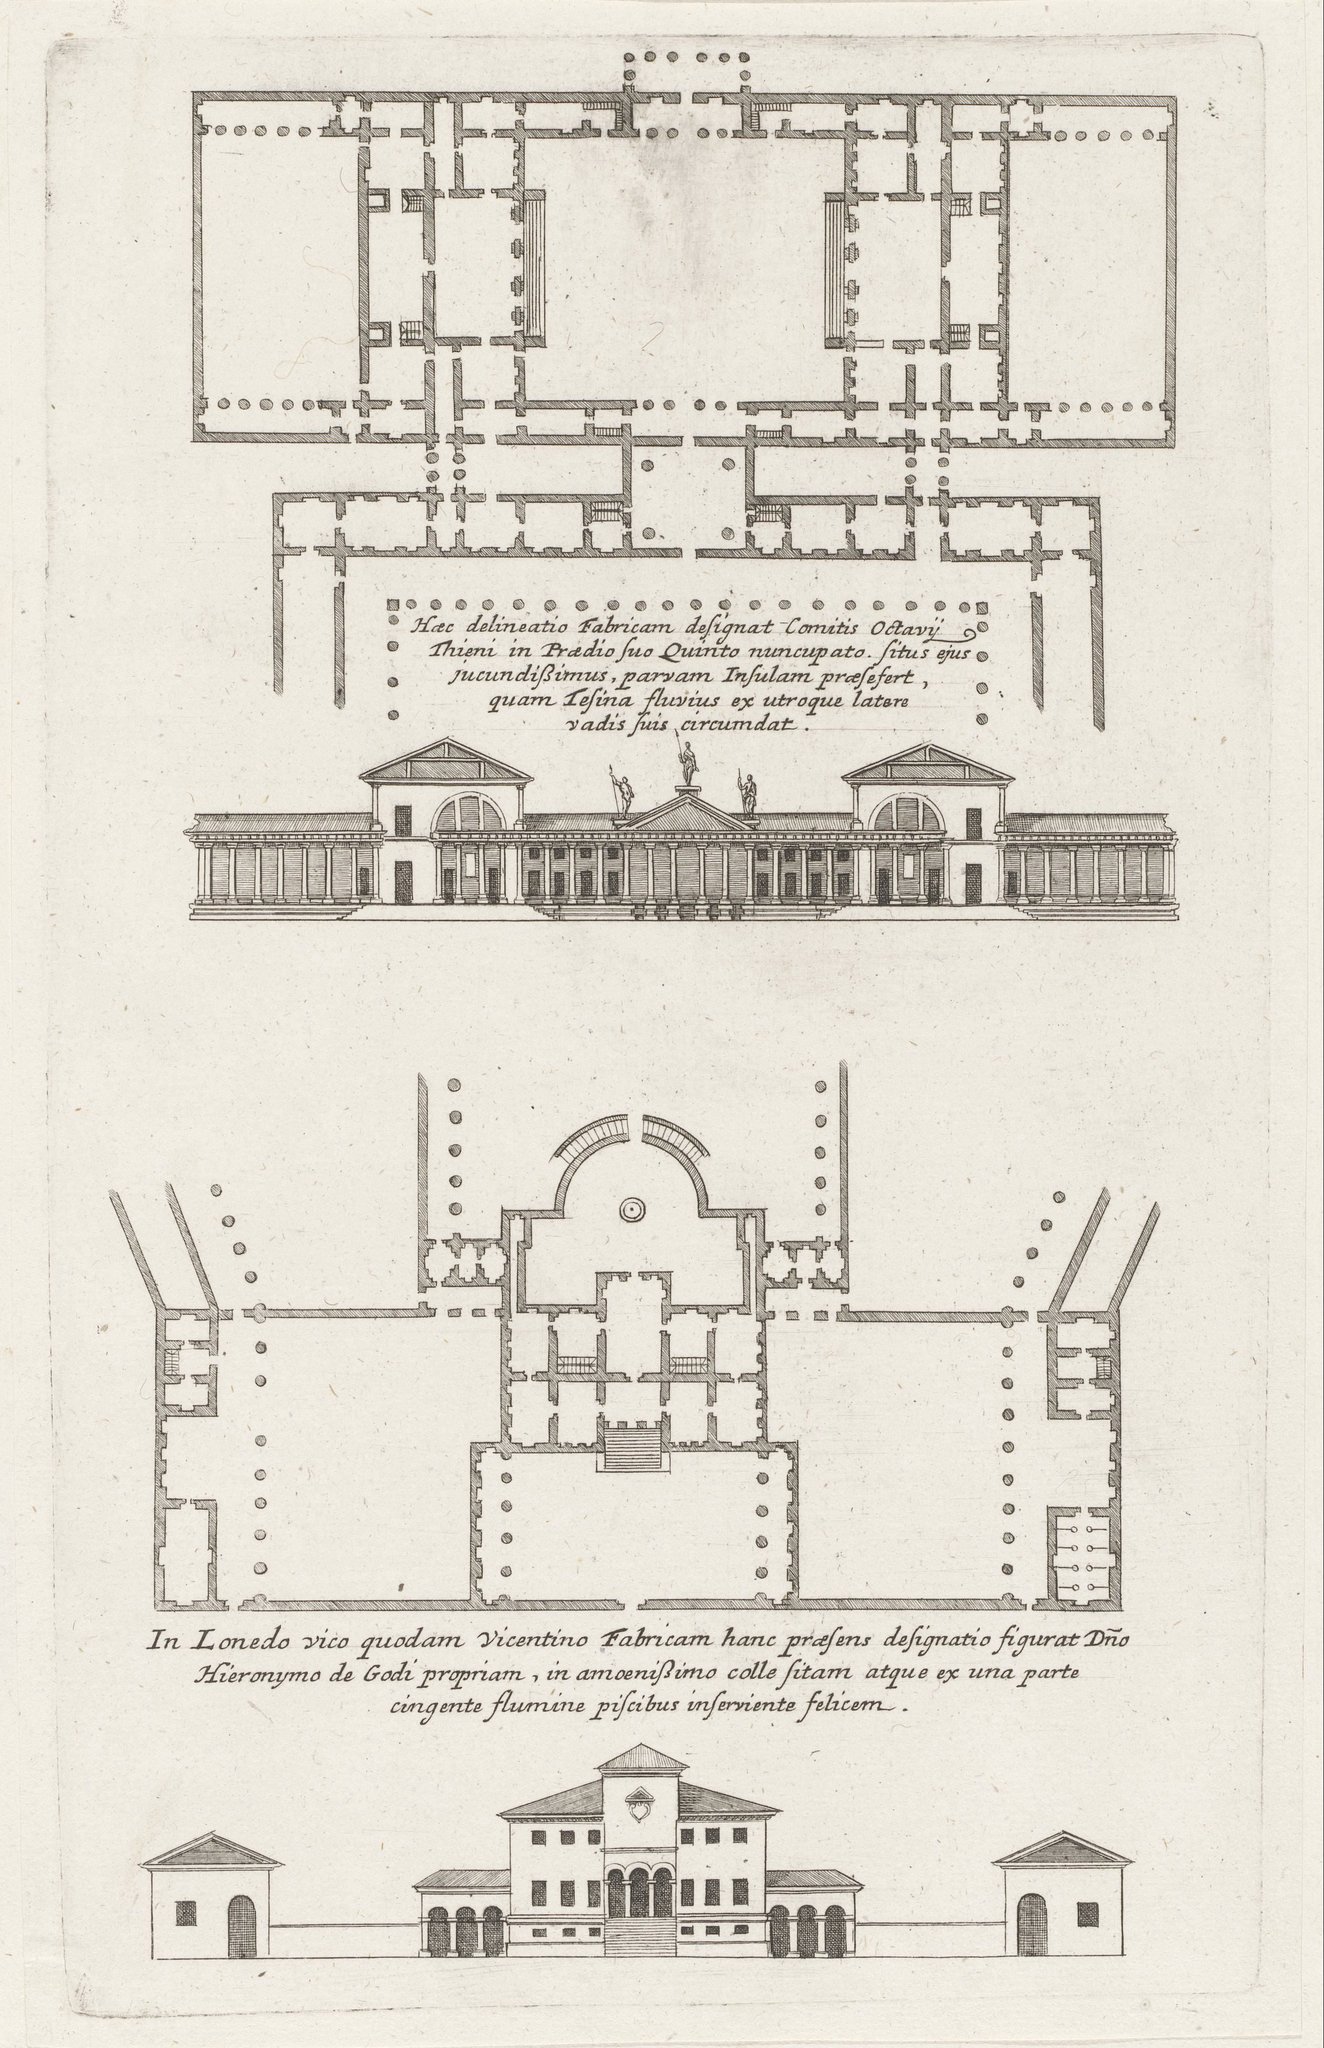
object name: print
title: Plattegronden en façades van twee villa's ontworpen door Andrea Palladio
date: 1600-1699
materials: paper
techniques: etching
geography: italy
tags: public baths